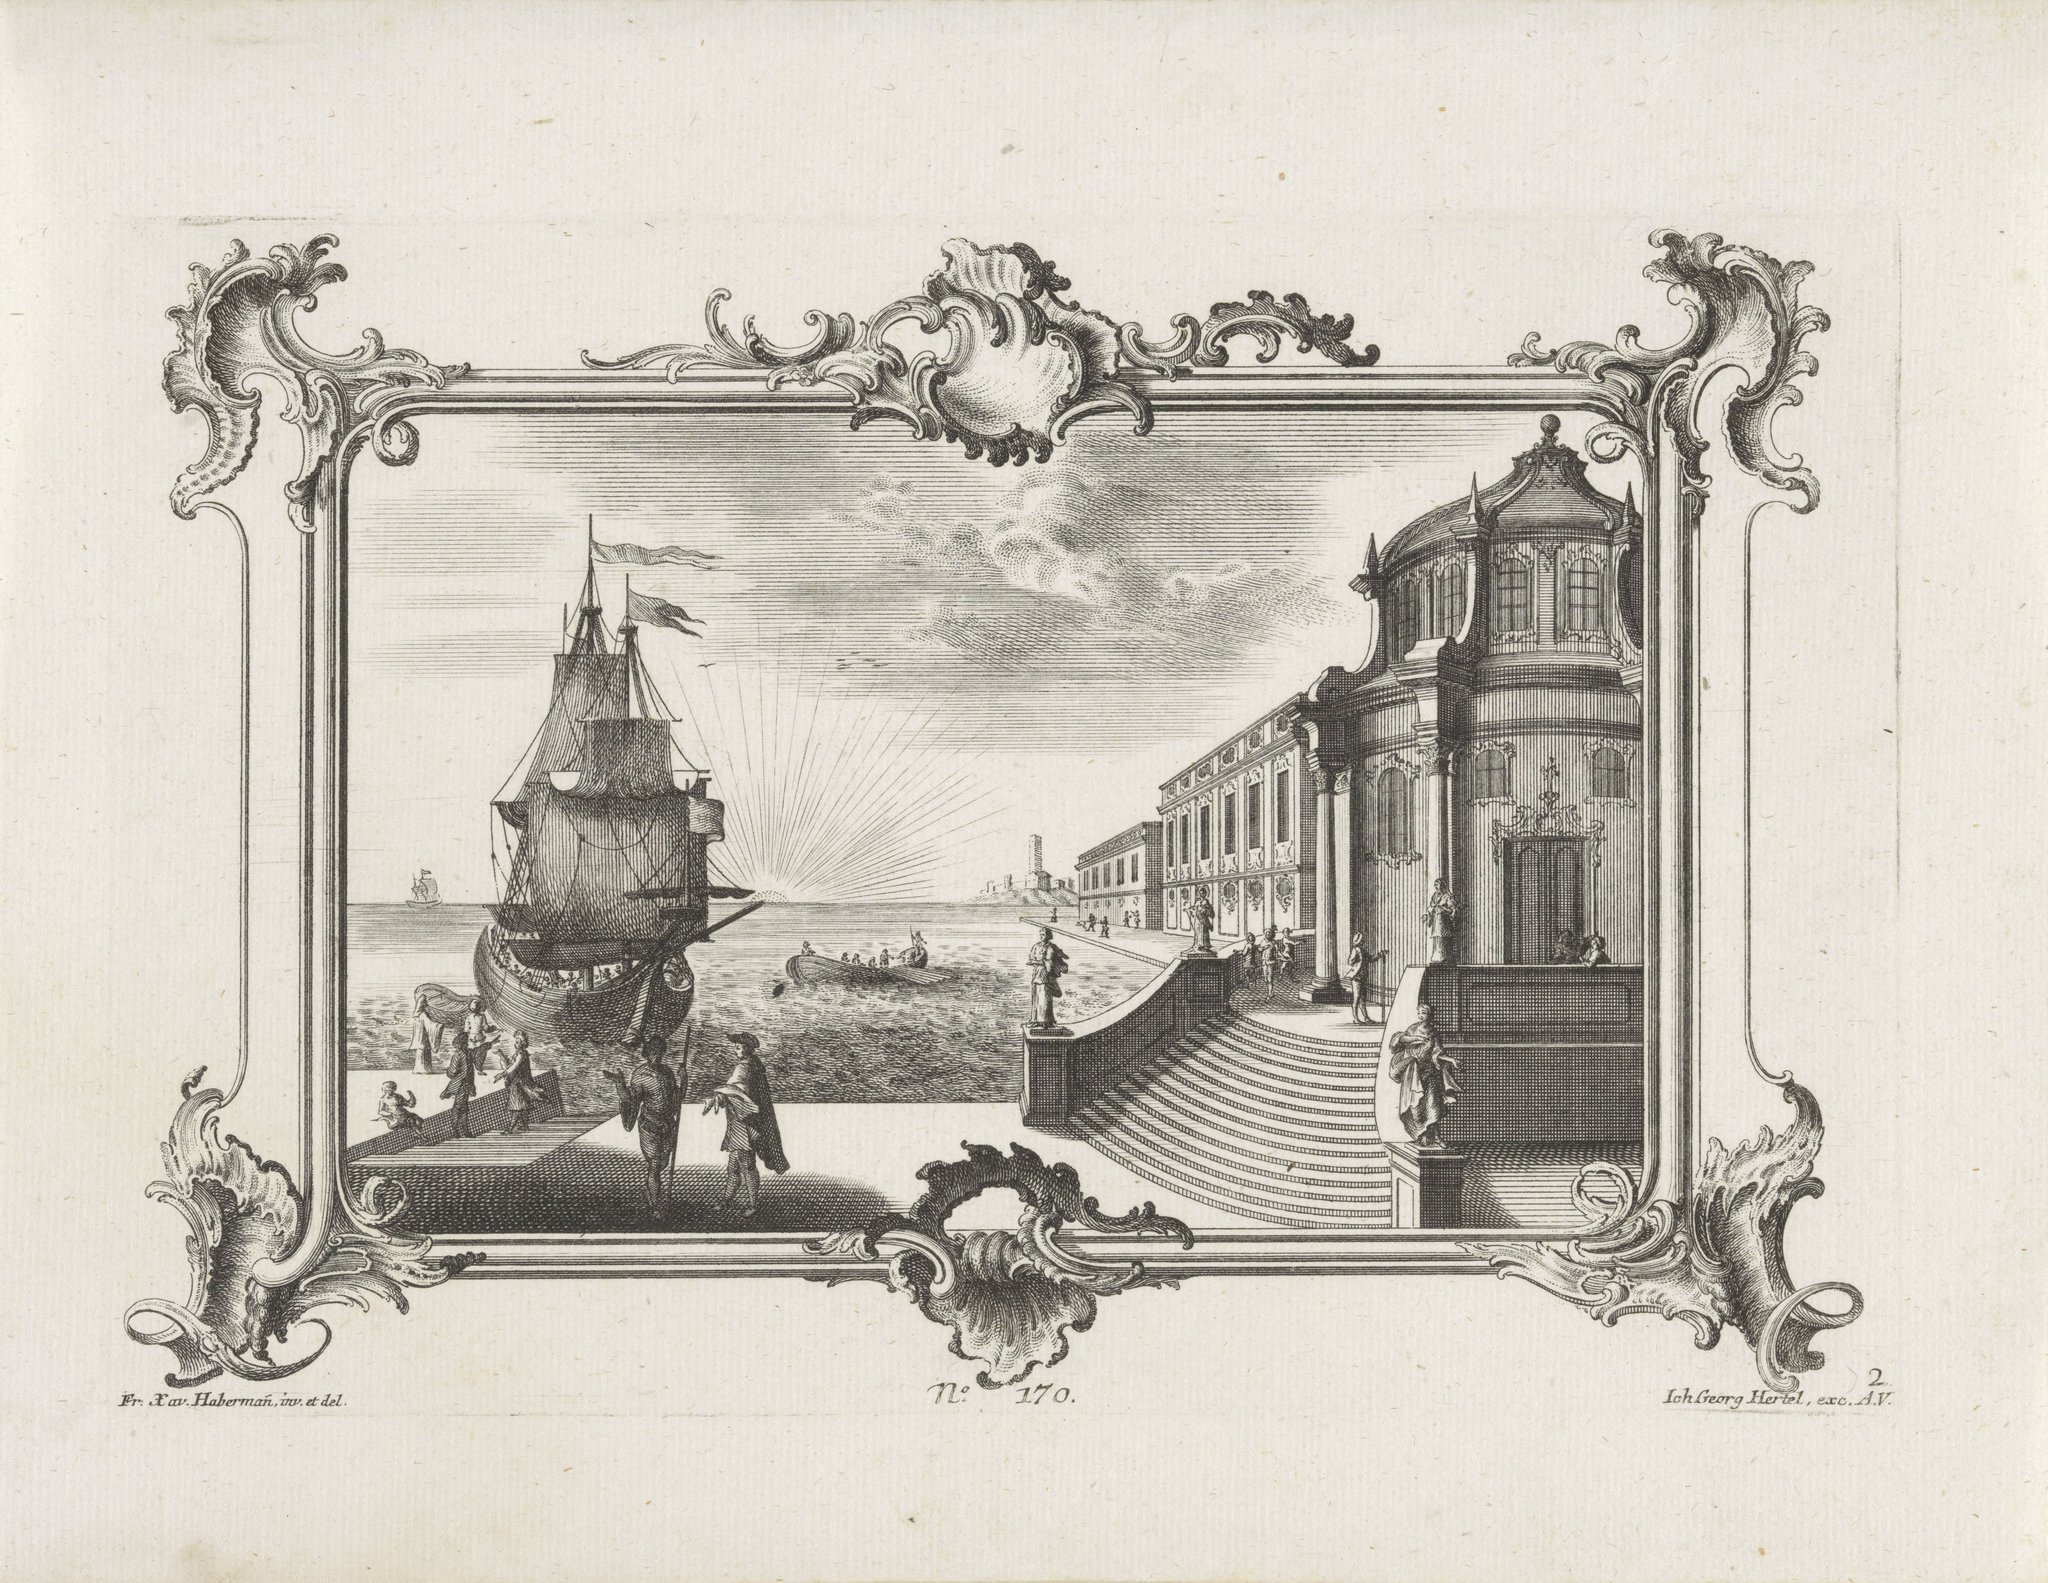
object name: ornament print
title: Paleis en trappen aan het water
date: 1731-1775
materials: paper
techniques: engraving, etching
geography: augsburg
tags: city-view, and landscape with man-made constructions, palace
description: In rocaille omlijsting een paleis met trappen aan het water. Een zeilschip en boot liggen in het water, figuren staan op de kade. Uitgeversnummer 170.